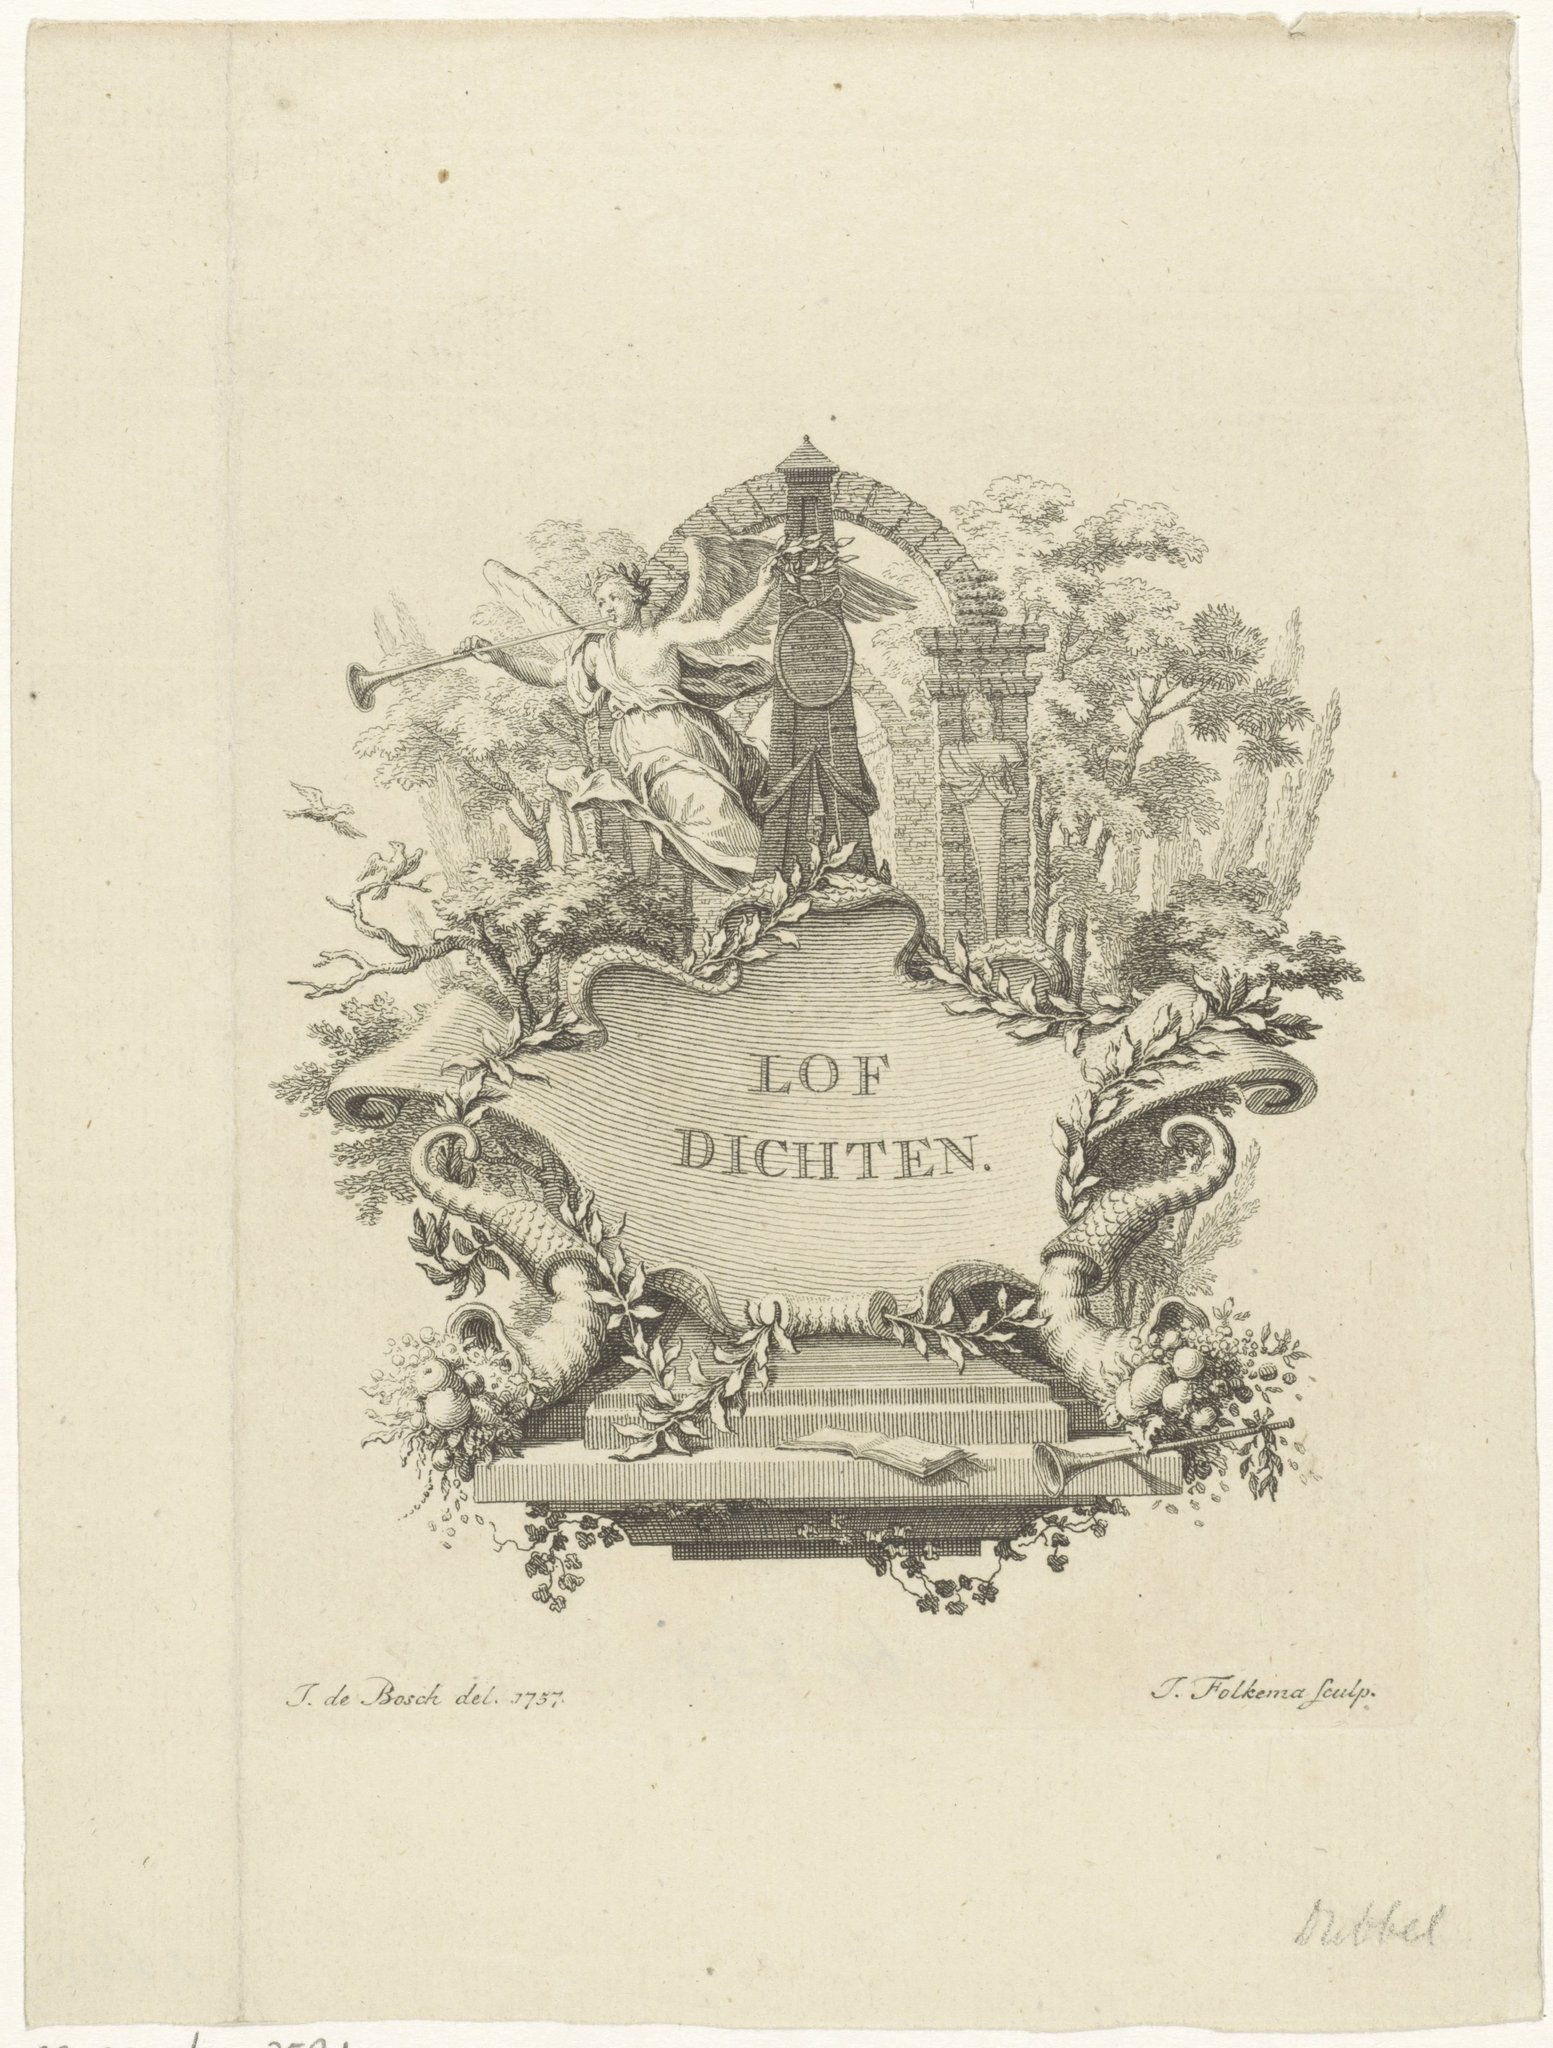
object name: print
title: Lofdichten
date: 1757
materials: paper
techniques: etching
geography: netherlands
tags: 'cornucopia', horn of plenty, other memorial structures, fame; 'fama', 'fama buona', 'fama chiara' (ripa)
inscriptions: collector's mark: Lugt 2228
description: Een met bladeren versierd cartouche staat op de voet van een gedenkzuil. Op de cartouche staat de titel, links en rechts hiervan zijn hoornen des overvloeds afgebeeld. Bij de top van de gedenkzuil vliegt een bazuin blazende engel met een lauwerkrans.